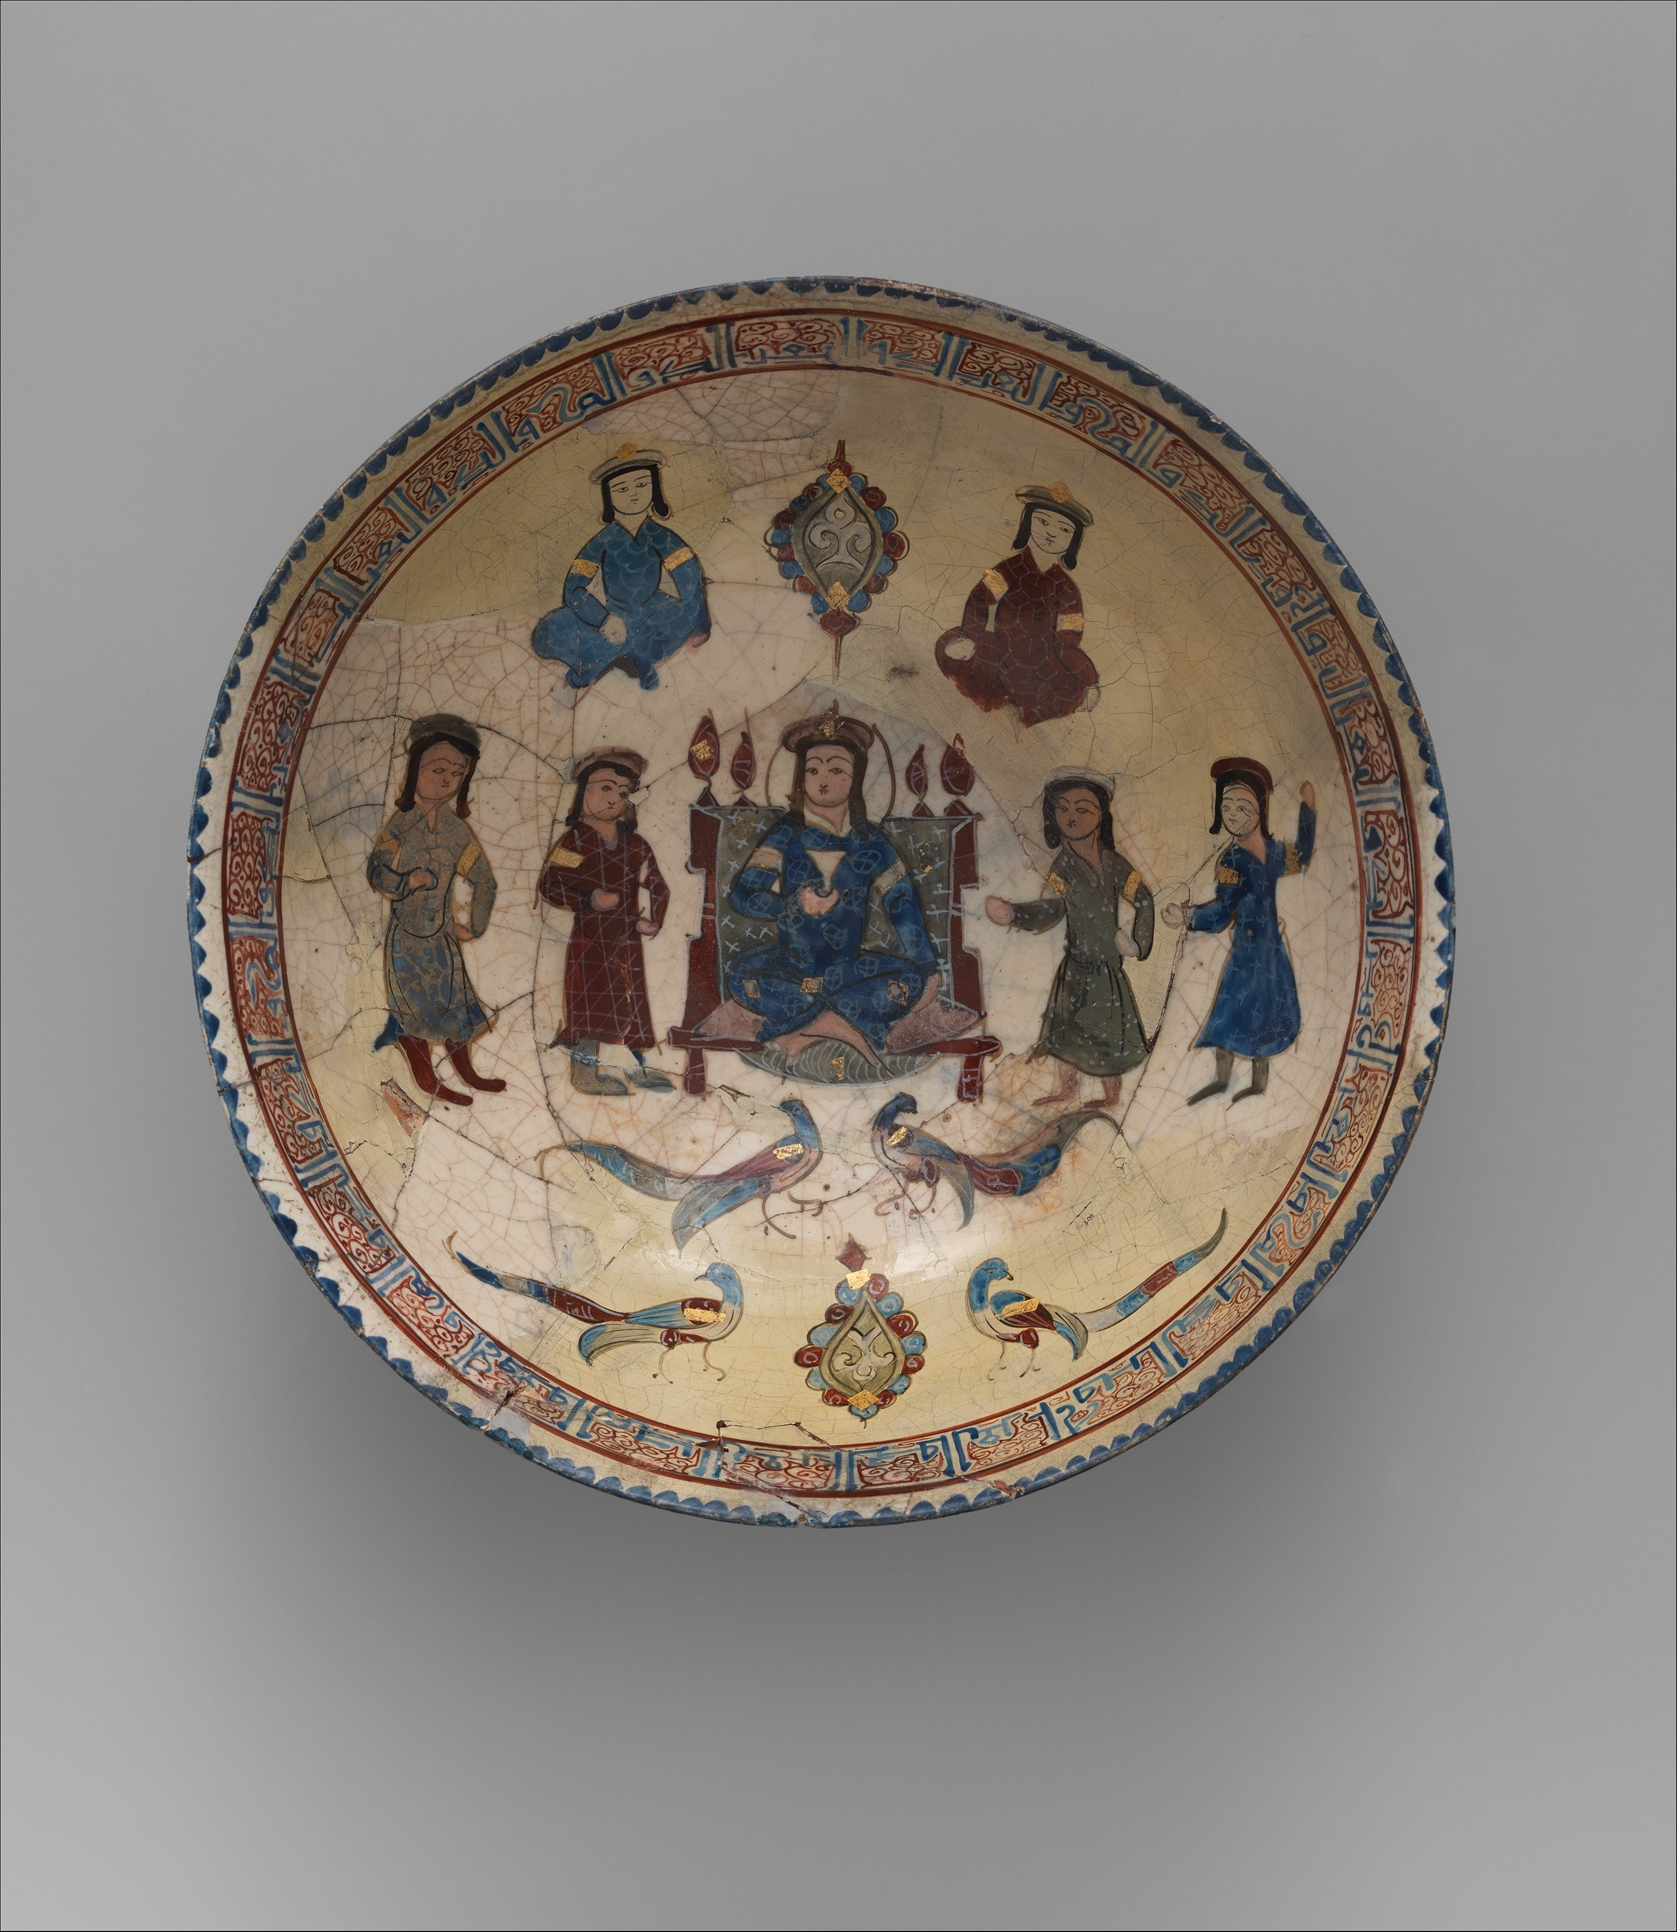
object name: bowl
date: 1201-1300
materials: stonepaste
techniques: overglaze, painting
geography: iran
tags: birds,men